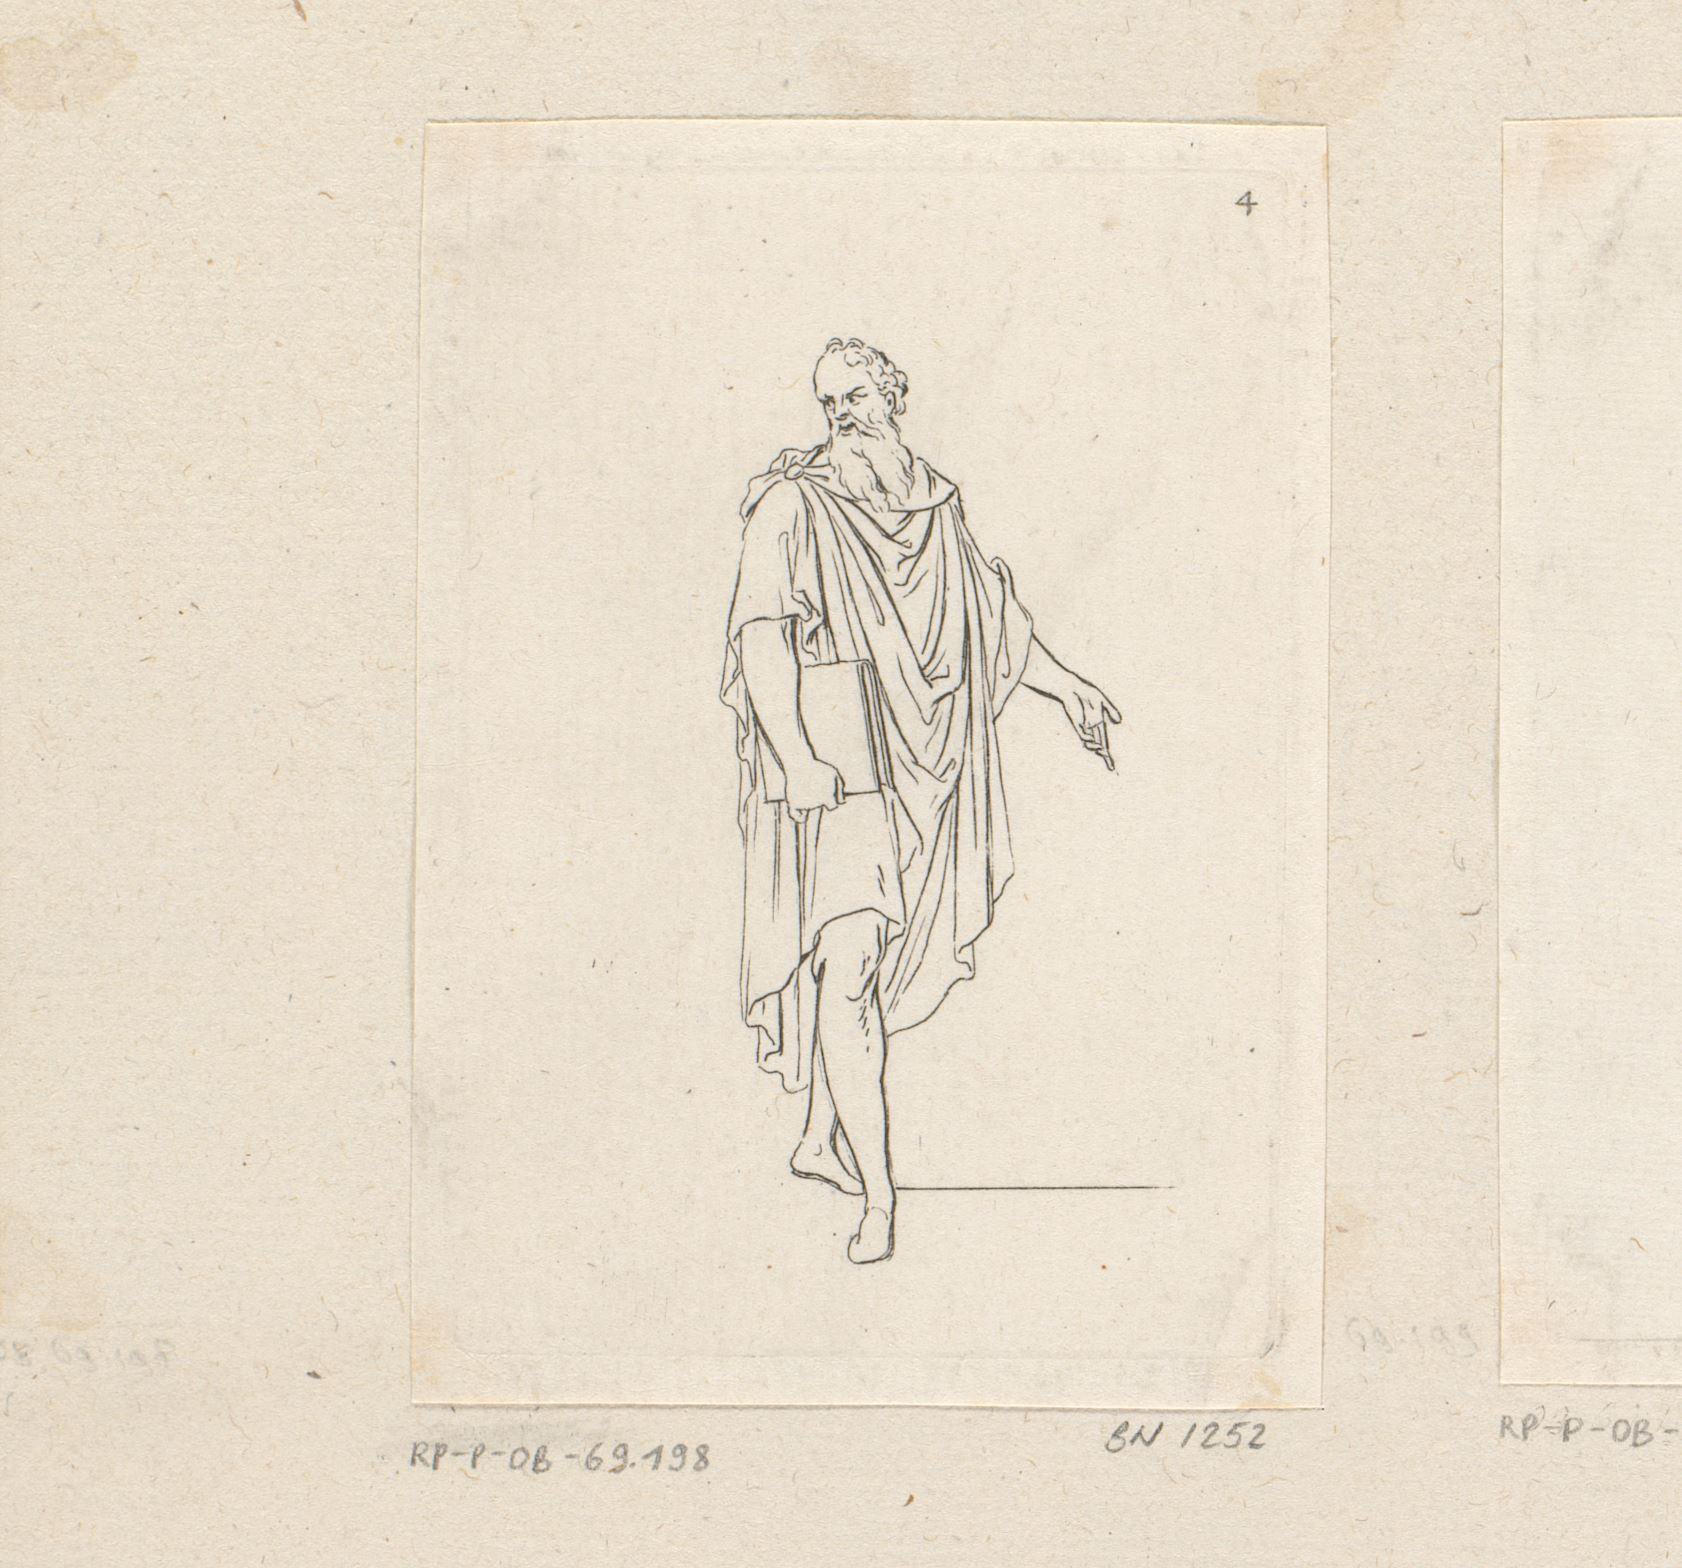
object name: print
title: Bebaarde man met boek onder zijn arm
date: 1706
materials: paper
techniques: etching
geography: paris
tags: adult man, book, beard